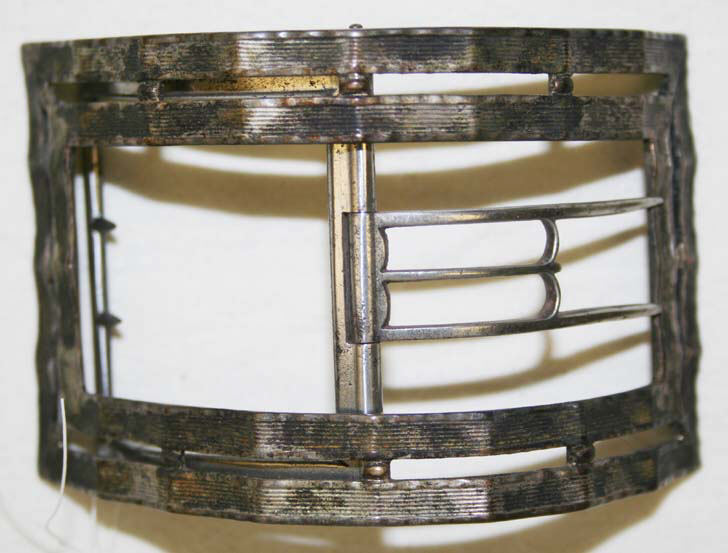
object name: shoe buckle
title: Shoe buckles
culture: british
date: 1784-1785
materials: silver